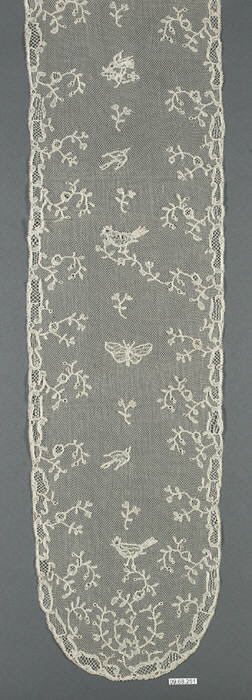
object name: lappet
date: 1801-1833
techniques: lace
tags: birds